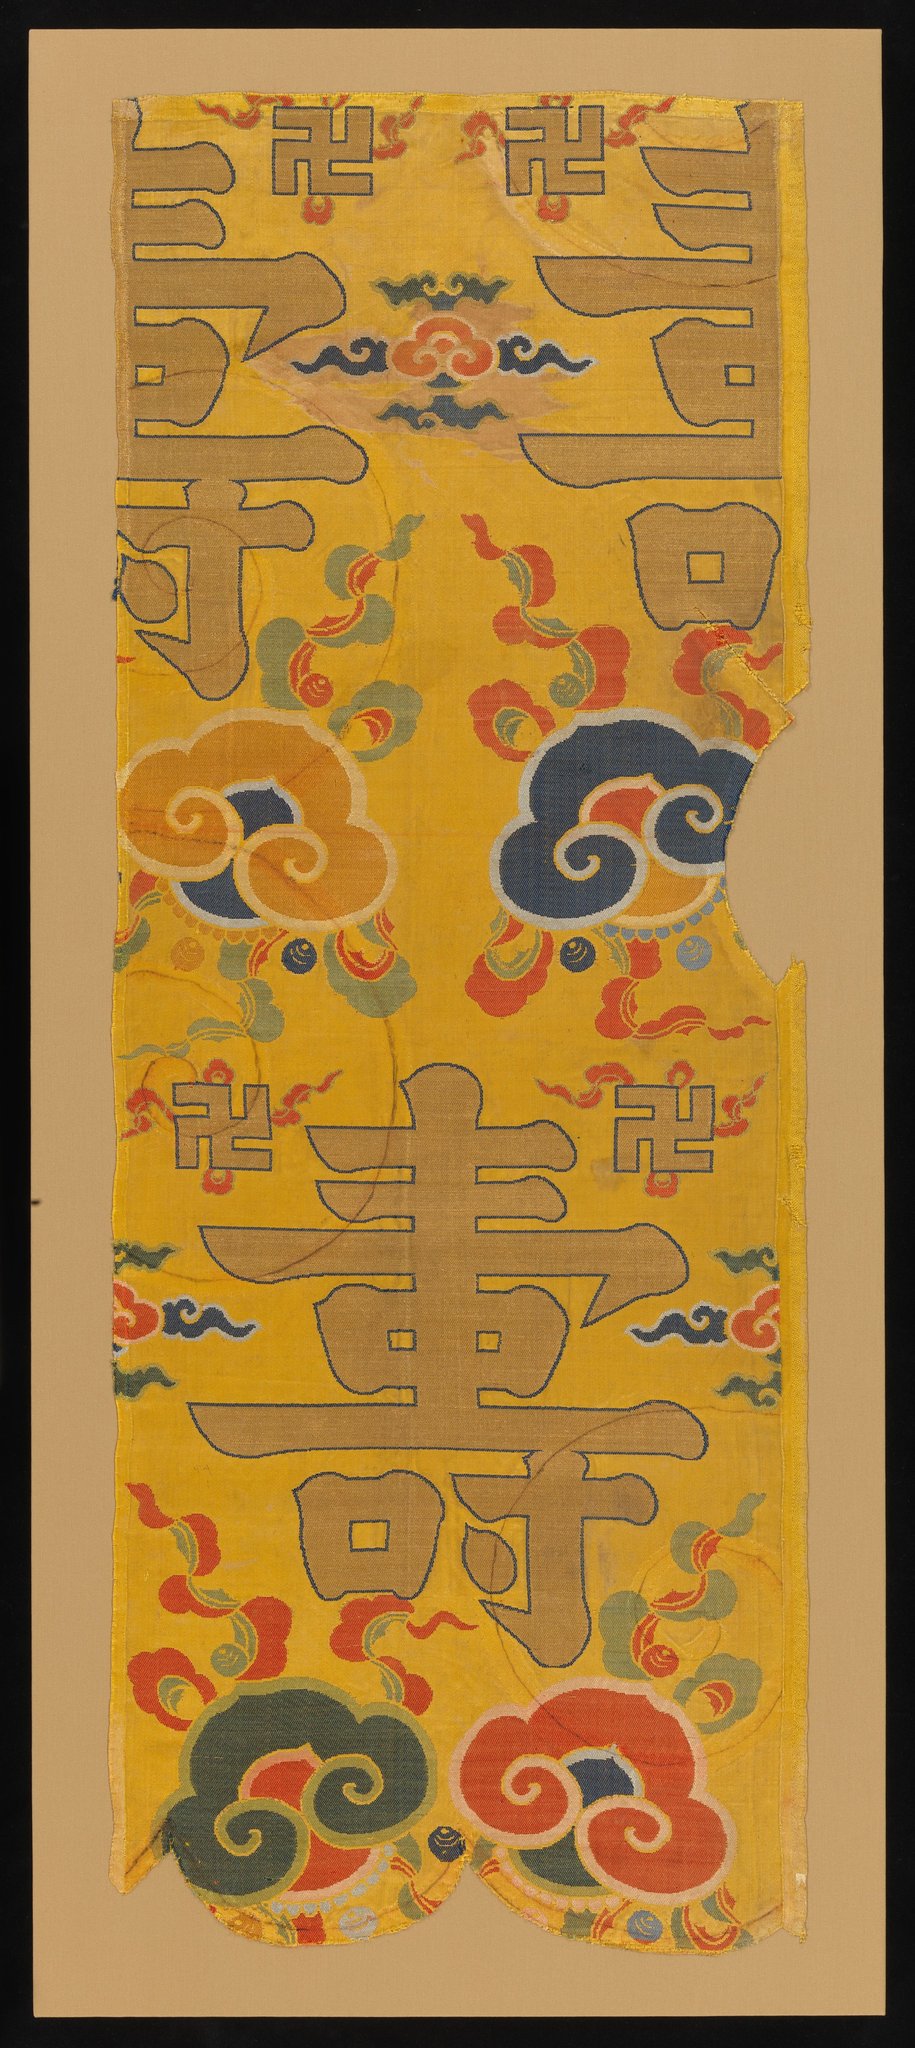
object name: piece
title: Textile with the Character for Longevity (Shou)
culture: chinese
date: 1601-1700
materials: silk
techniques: brocade